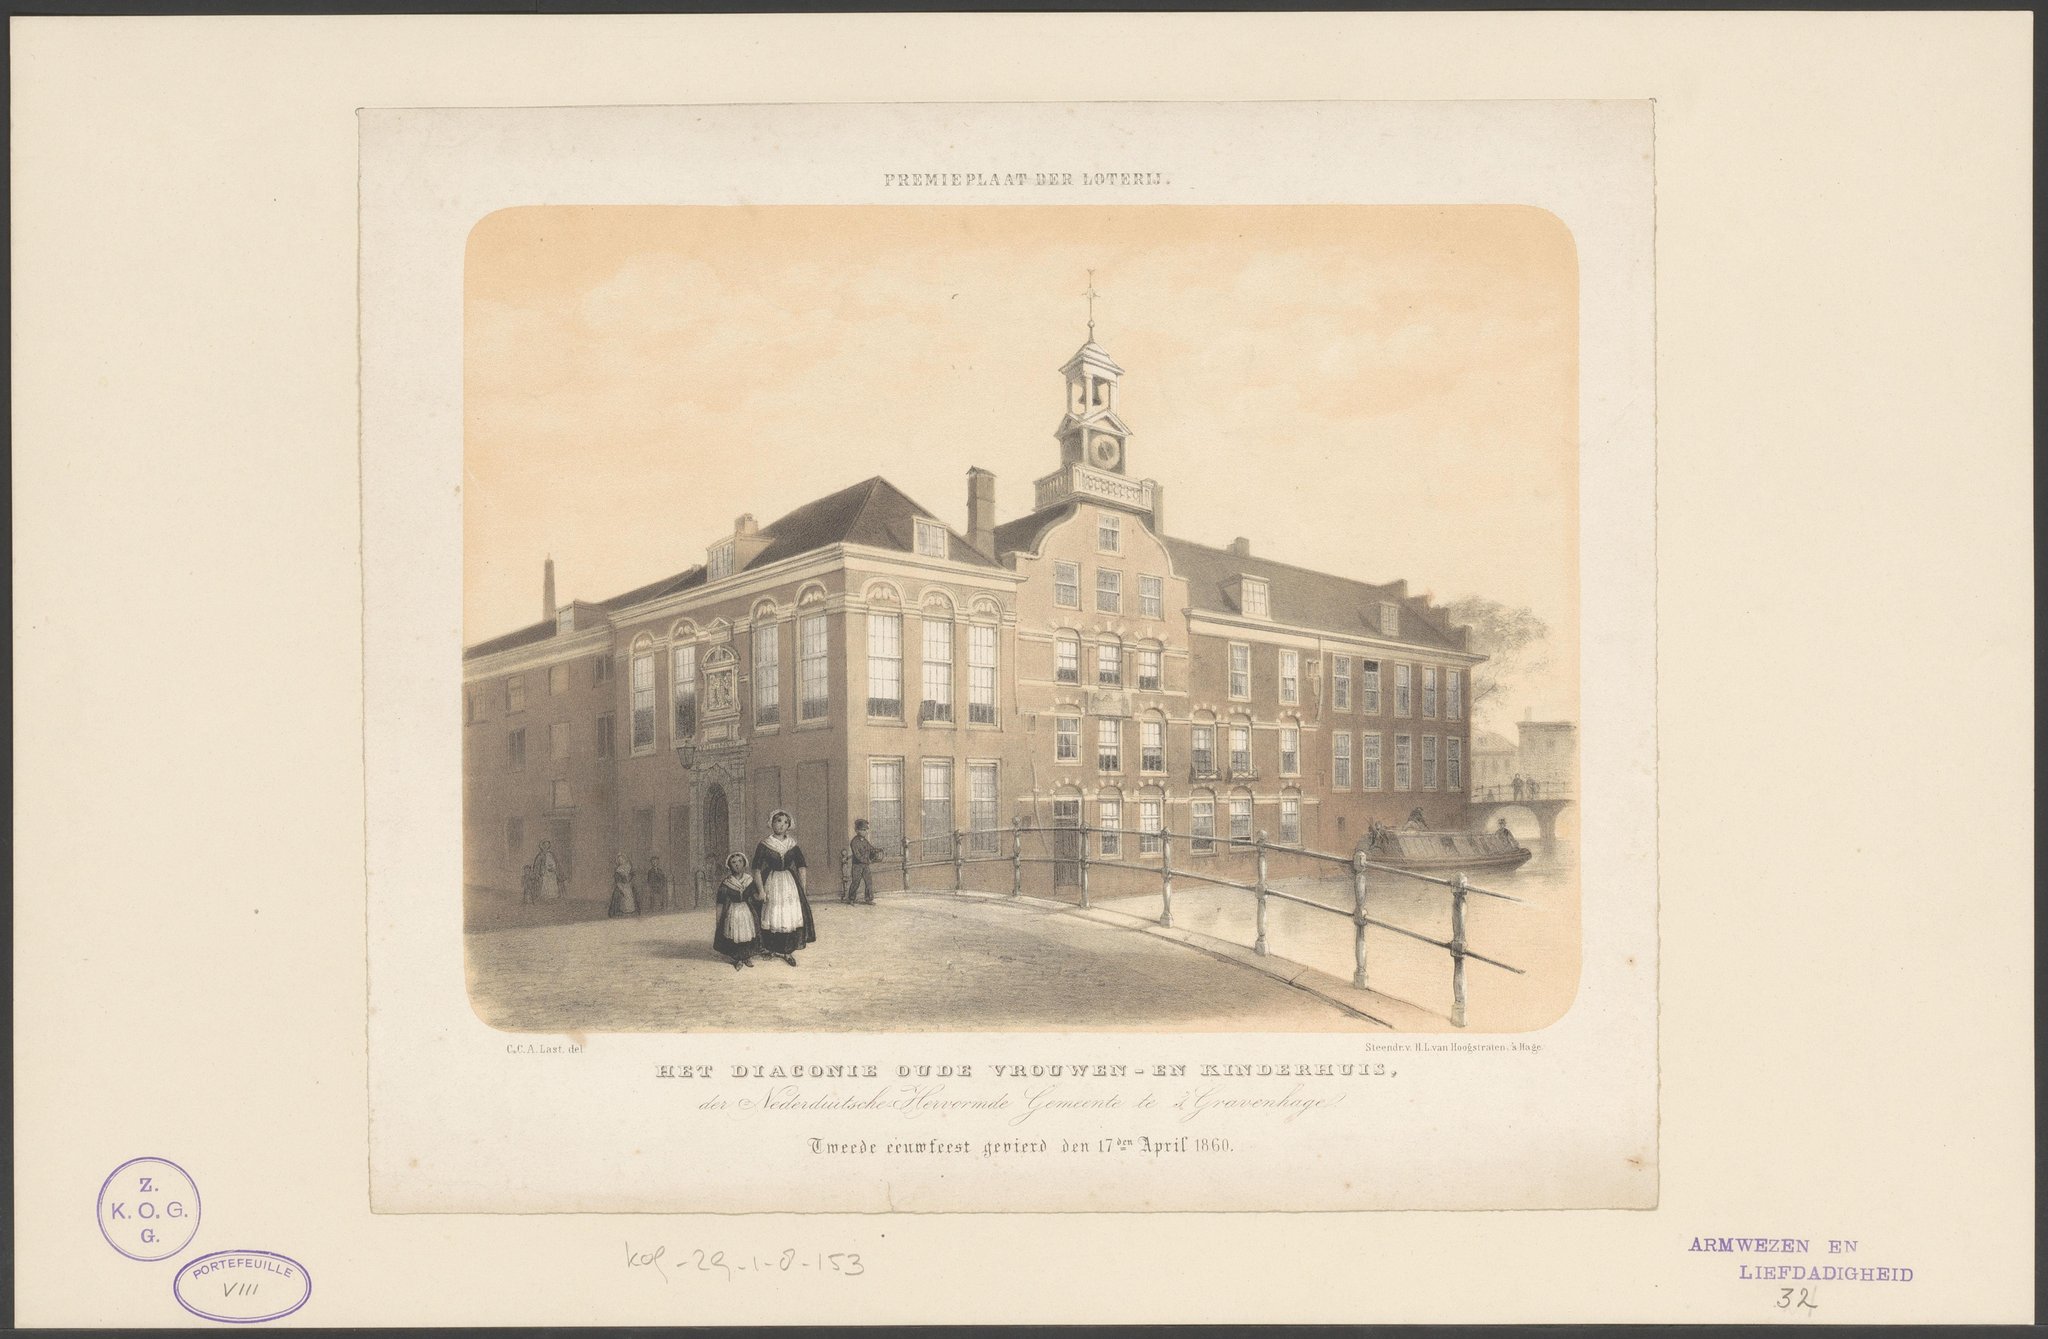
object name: print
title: Het Diaconie Oude Vrouwen en Kinderhuis, der Nederduitsche Hervormde Gemeente te 's Gravenhage. Tweede eeuwfeest gevierd den 17den april 1860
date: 1860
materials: paper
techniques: tone lithography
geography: the hague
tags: orphanage, bridge in city across river, canal, etc., charitable works, old-people's home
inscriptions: collector's mark: Lugt 1641, collector's mark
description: Gezicht op het Diaconie Oude Vrouwen- en Kinderhuis in Den Haag. Bij het tweehonderdjarig bestaan in 1860. Onderwerpsrubrieken binnen de Atlas Zeden en Gewoonten: Armwezen en Liefdadigheid.